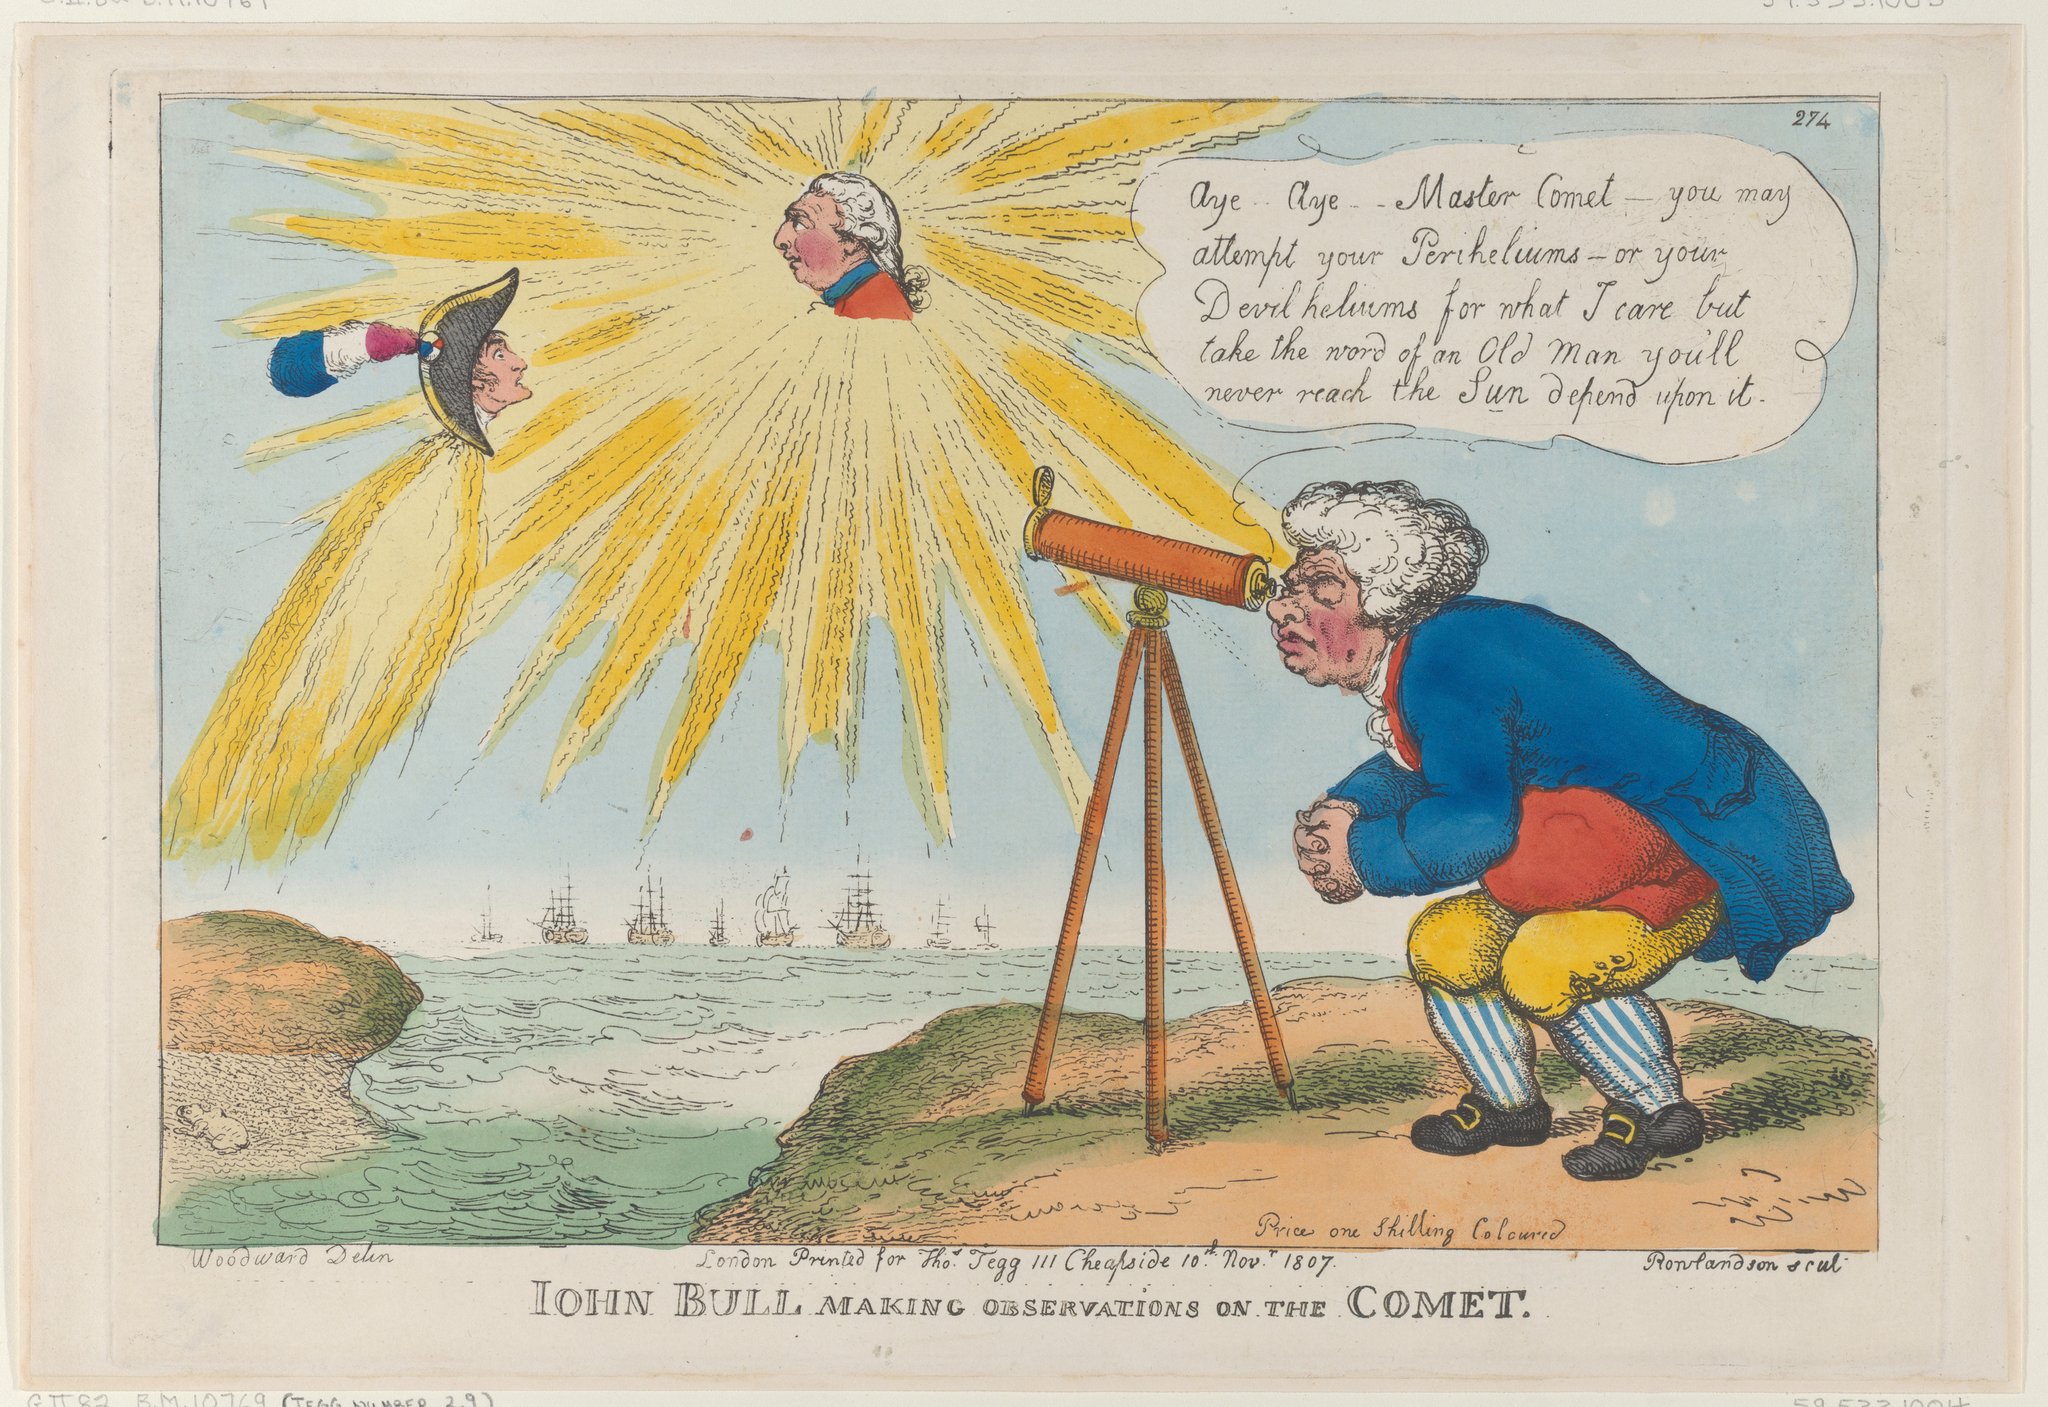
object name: print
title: John Bull Making Observations on the Comet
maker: thomas rowlandson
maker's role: artist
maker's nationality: british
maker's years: 1757-1827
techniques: etching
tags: satire,napoleon i,men,telescopes